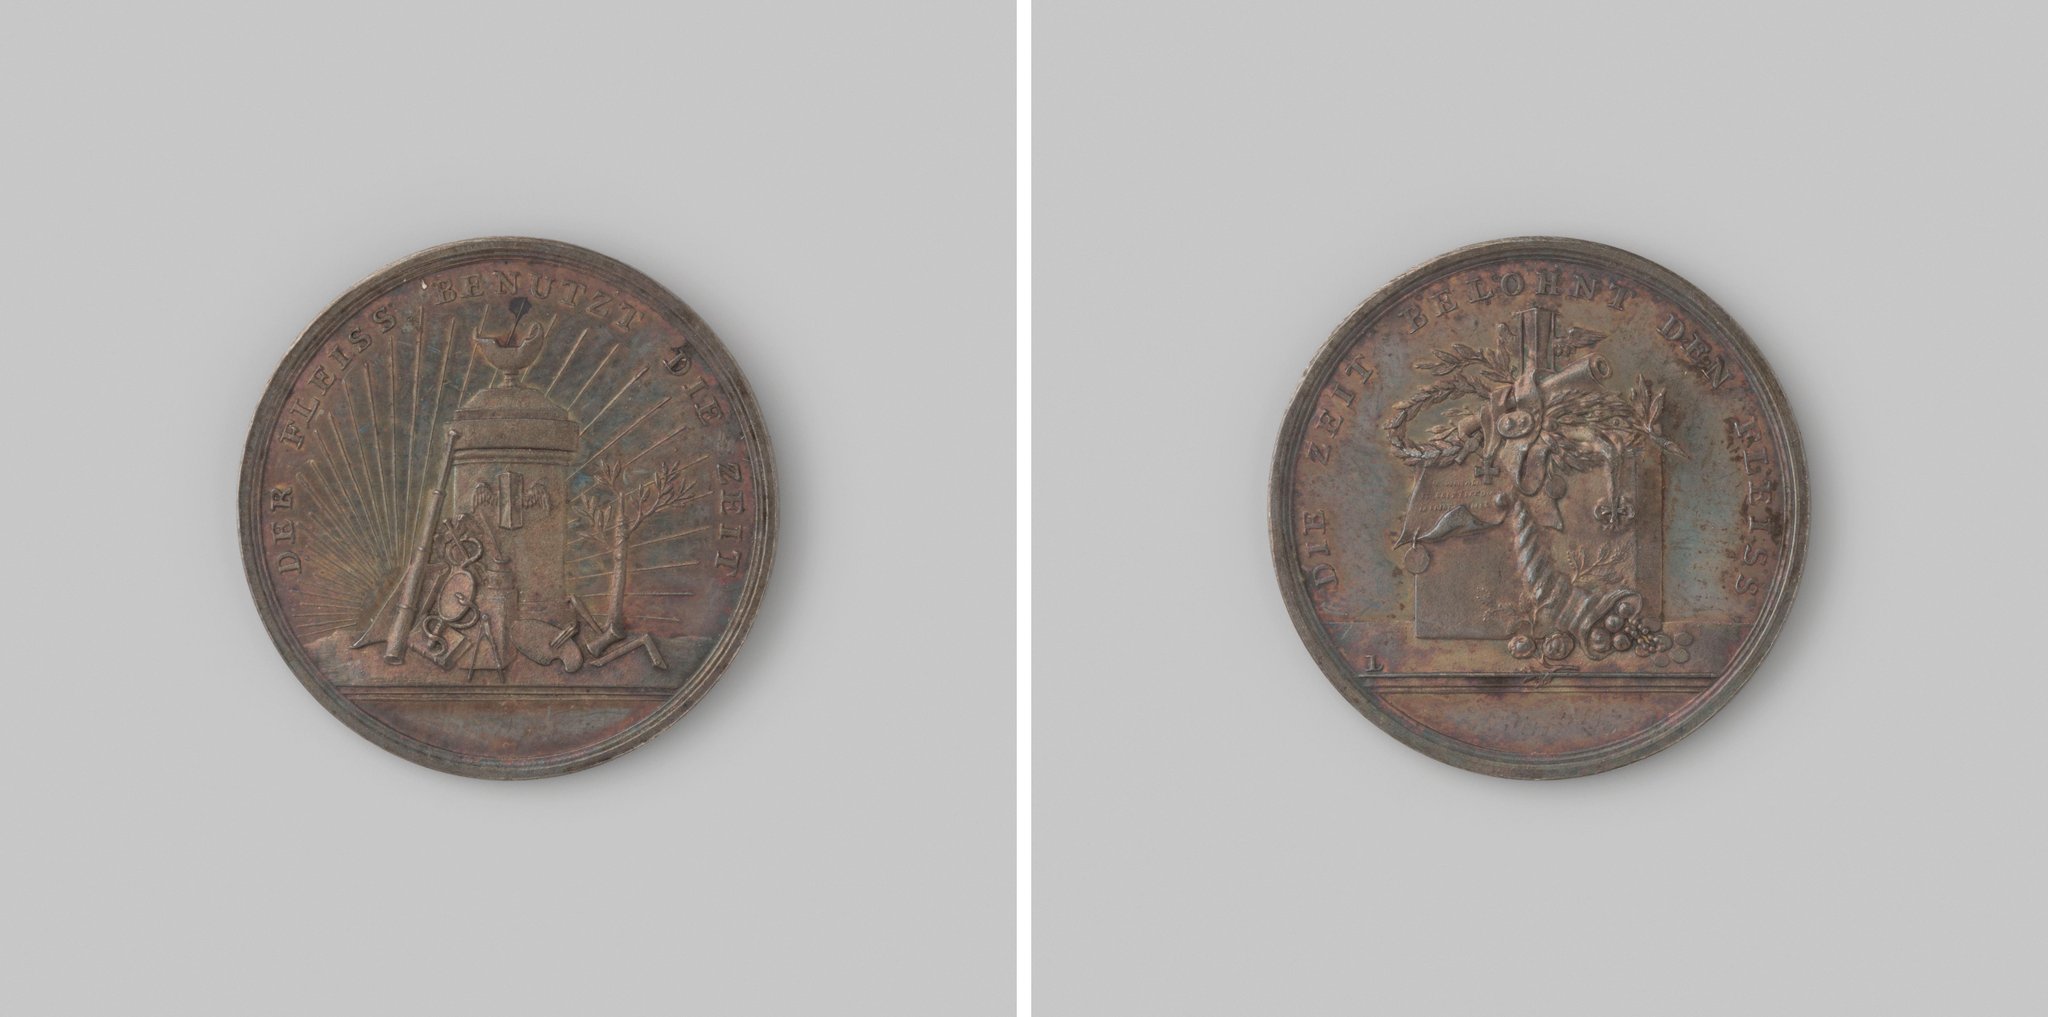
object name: history medal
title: Duitse avondmaalspenning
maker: loos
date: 1800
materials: silver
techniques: striking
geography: berlin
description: Zilveren penning, op de voorzijde een zonbeschenen grafzuil te midden van allerhande symbolen, met omschrift, op de keerzijde een altaar met ereblijken, met omschrift.